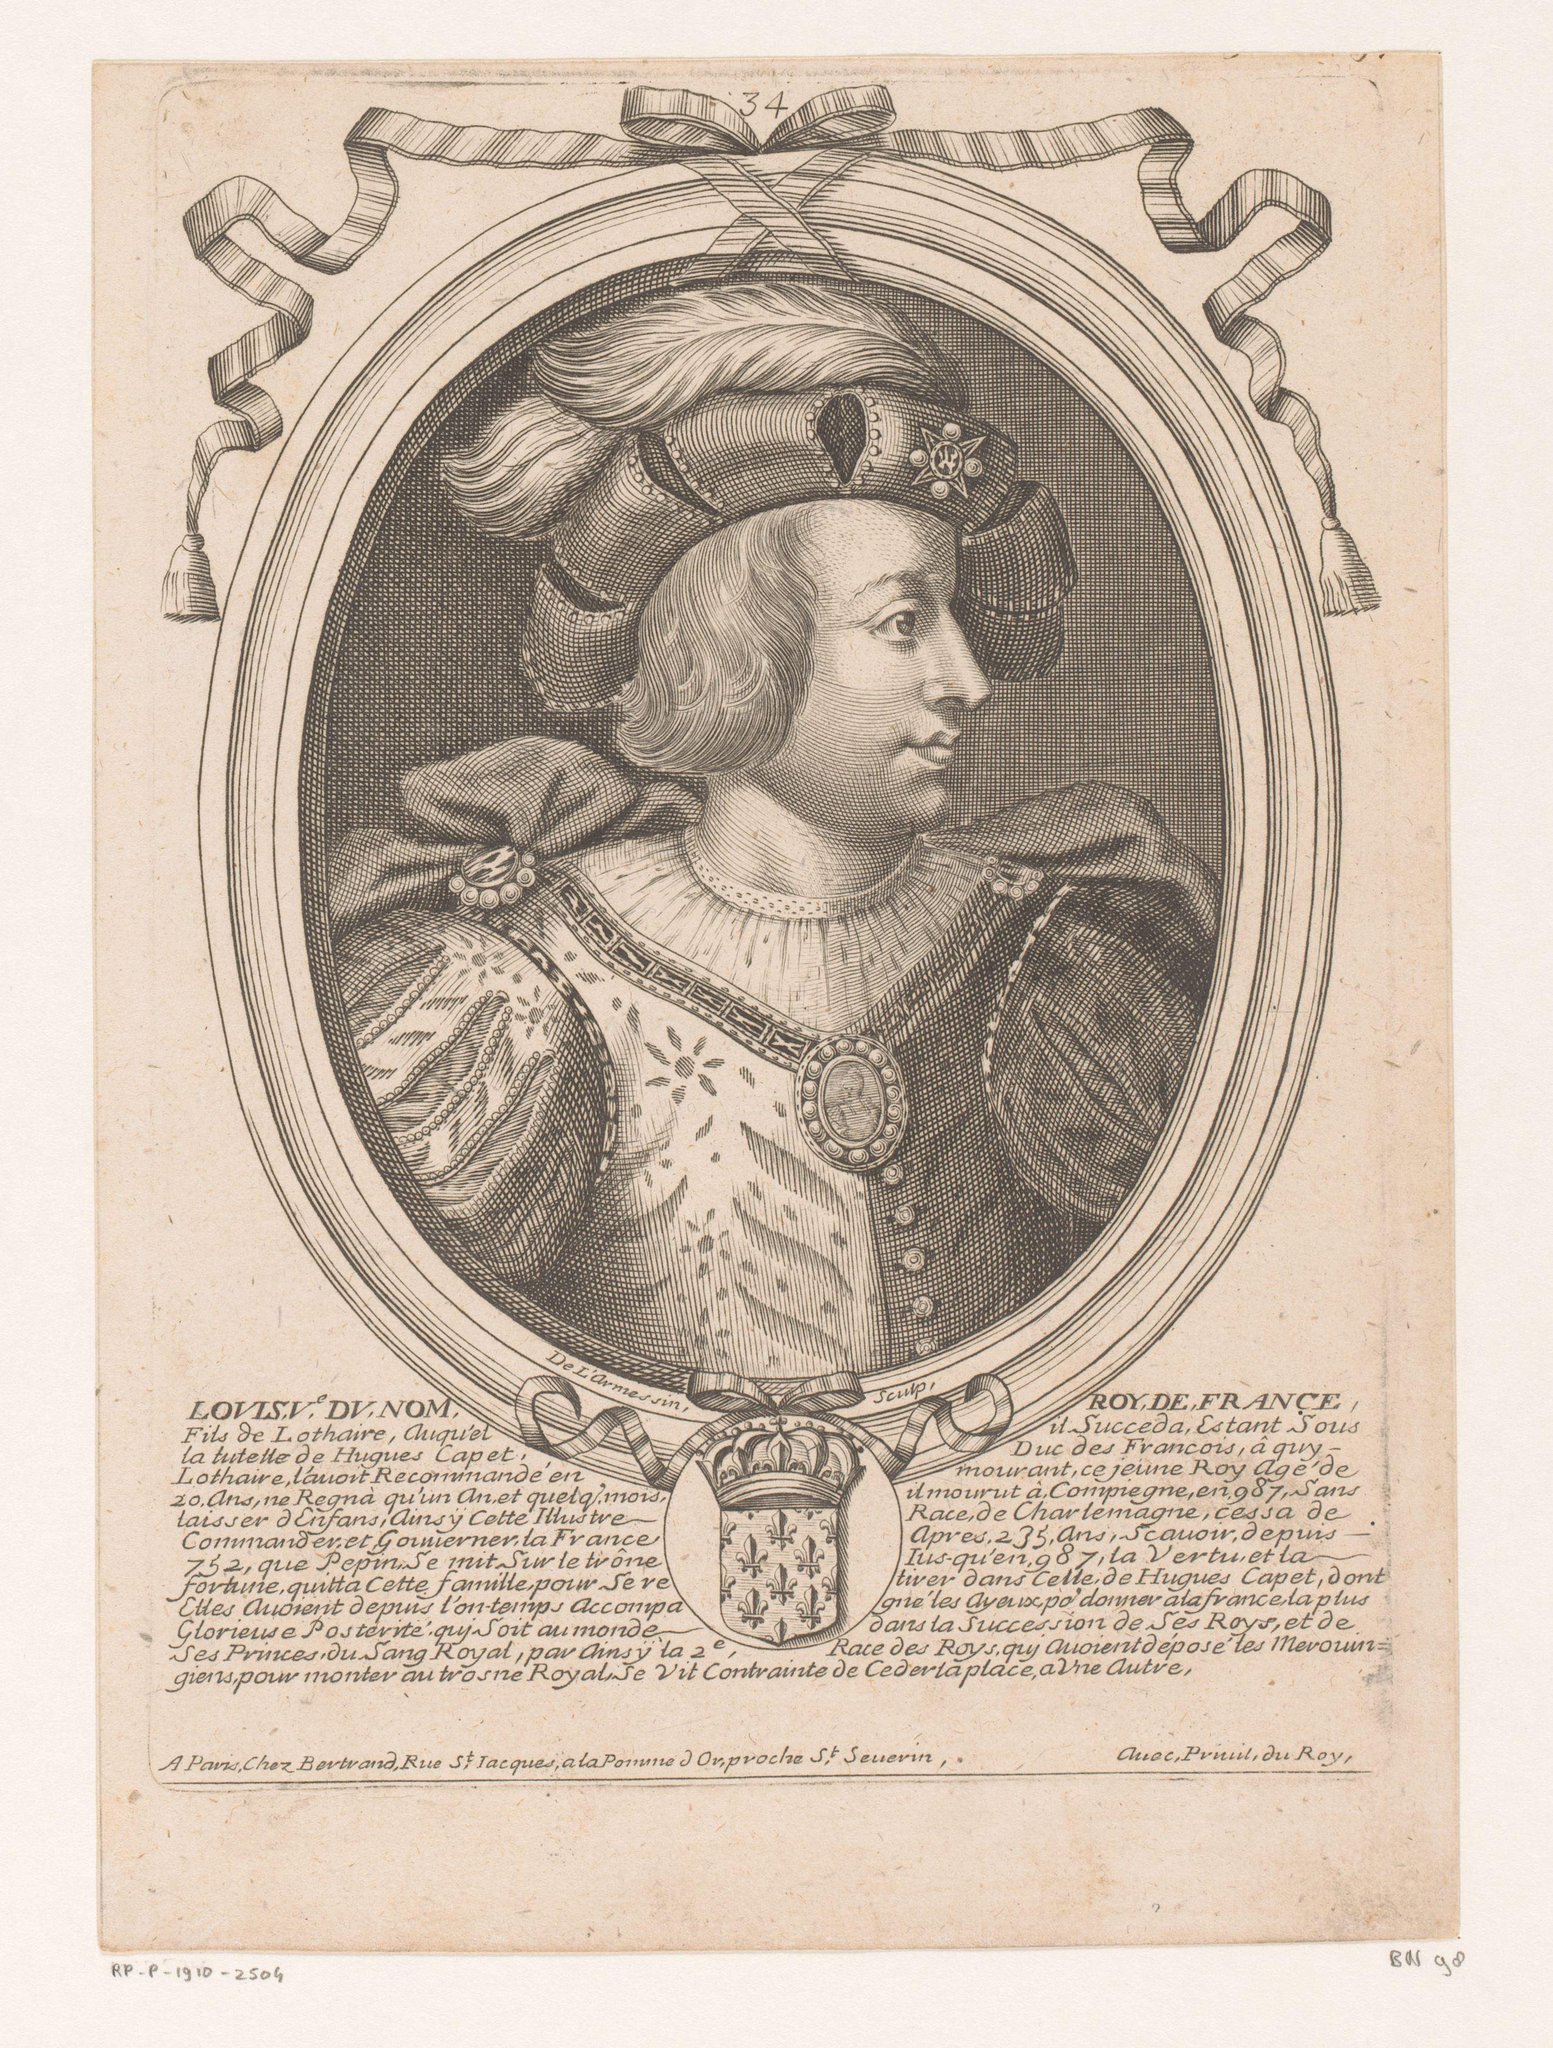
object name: print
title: Portret van Lodewijk V, koning van West-Francië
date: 1642-1678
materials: paper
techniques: engraving, etching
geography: paris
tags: historical persons, king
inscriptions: collector's mark: Lugt 2228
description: Maakt deel uit van een grootschalige serie met portretten van prominente figuren. Binnen de serie bevindt zich een sectie getiteld 'Les Augustes Représentations De tous les Roys De France depuis Pharamond Iusqu'à Louys XIIII'. De serie werd respectievelijk uitgegeven door Pierre Bertrand, door zijn weduwe en door De Larmessin zelf.